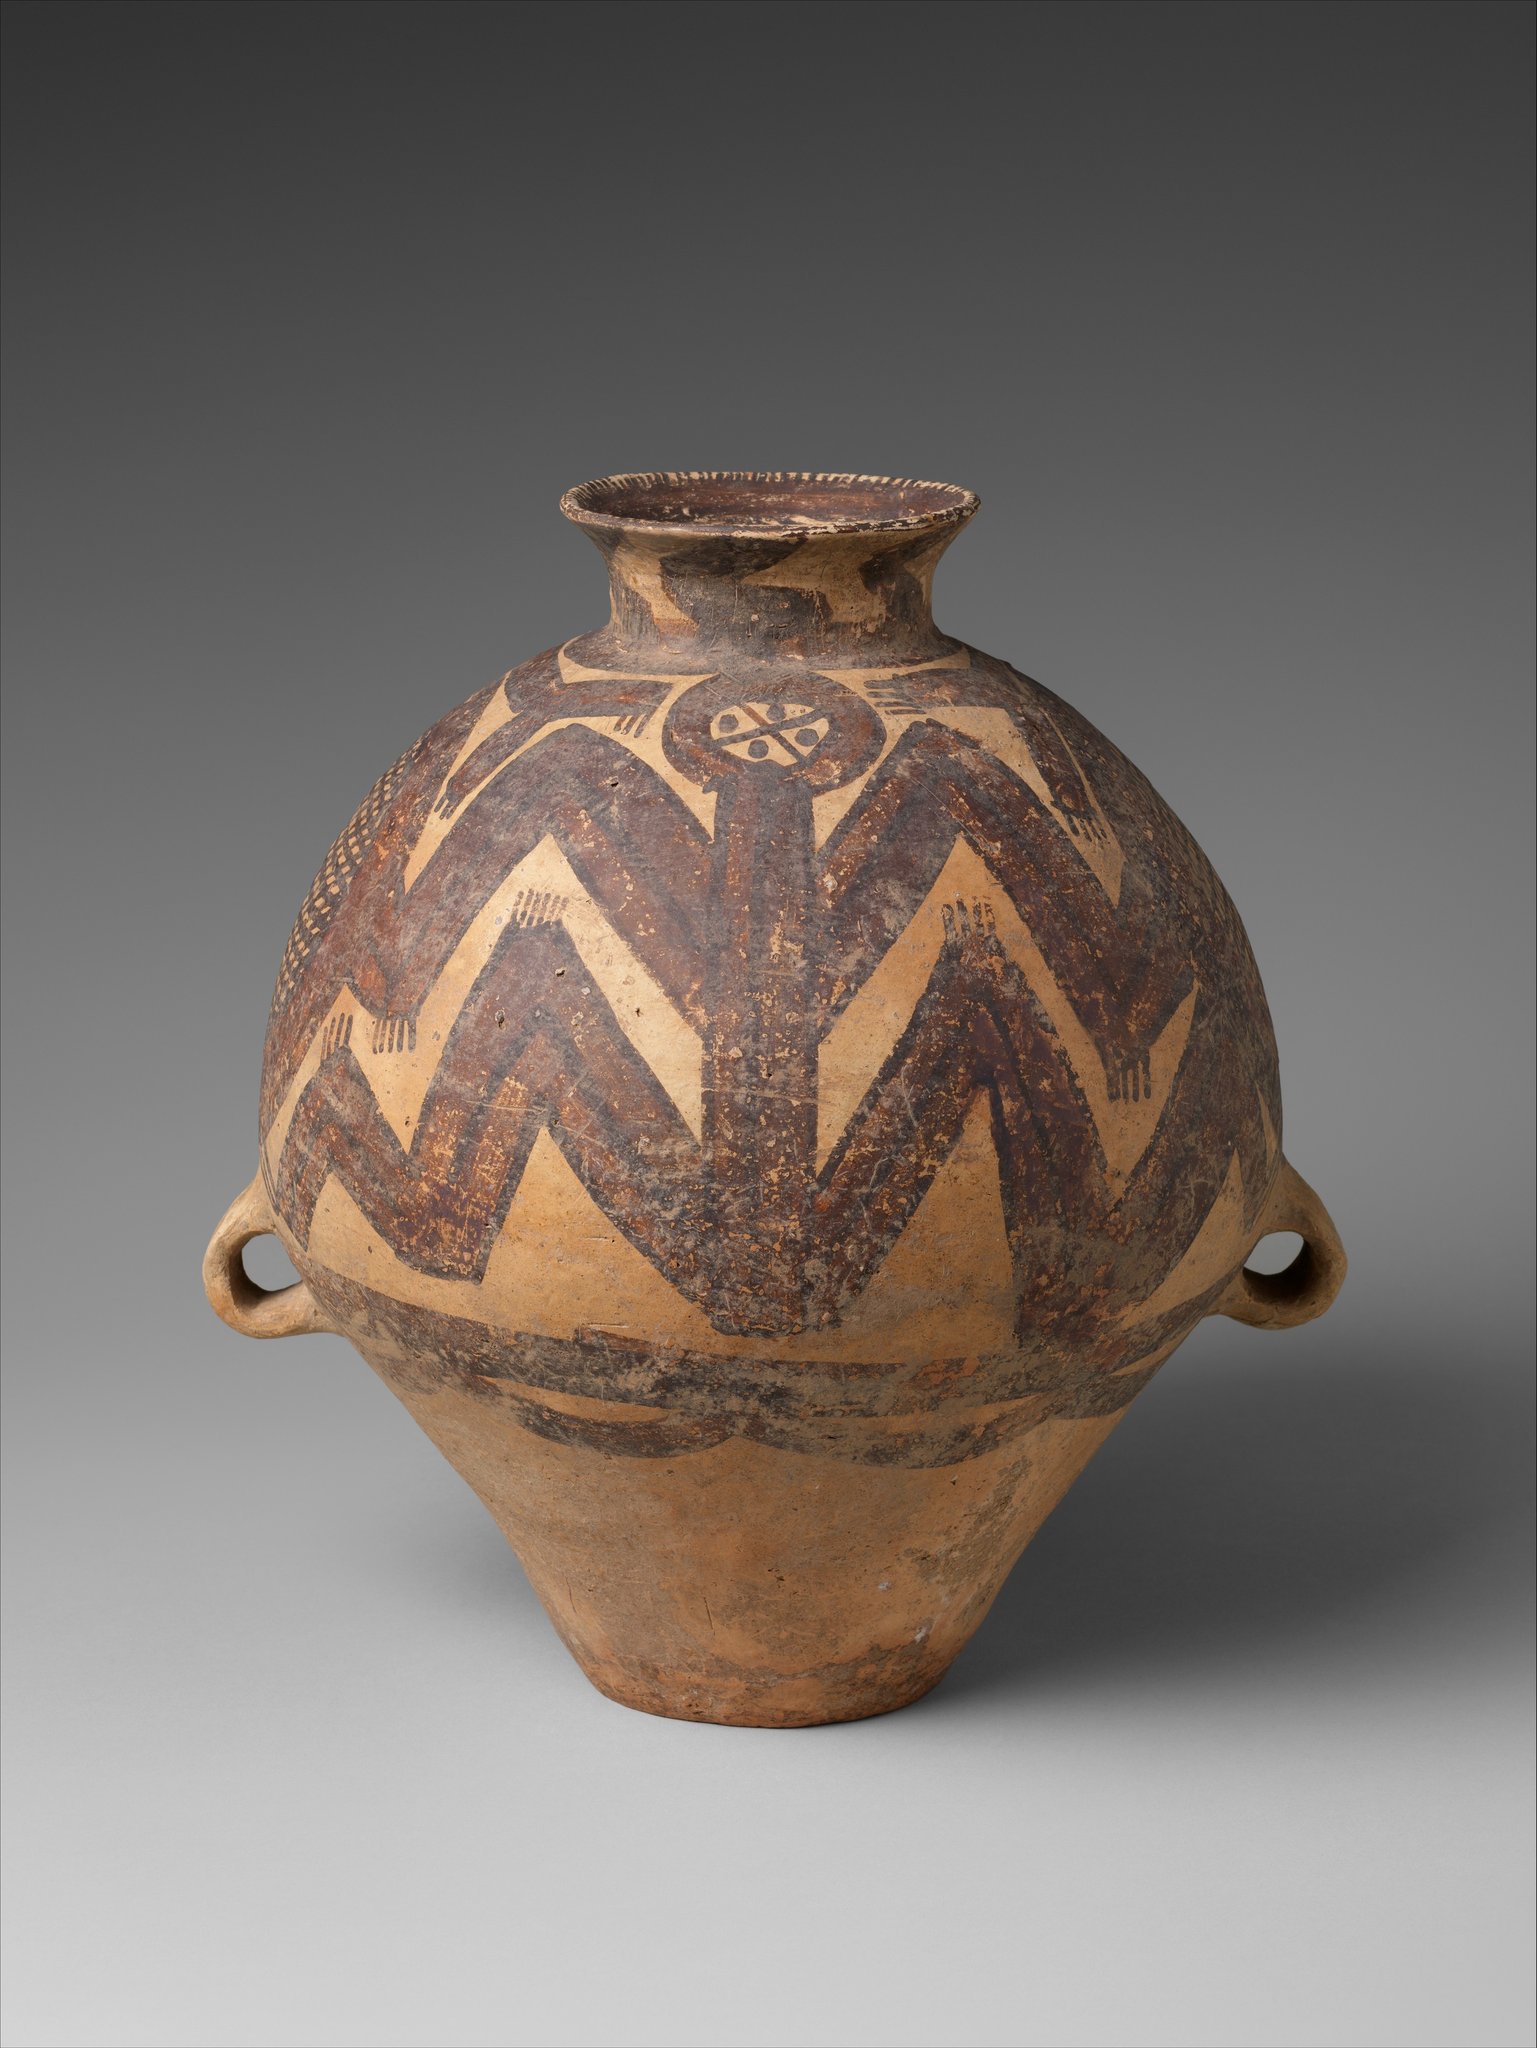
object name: jar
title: Jar (Guan)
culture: chinese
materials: earthenware, pigment